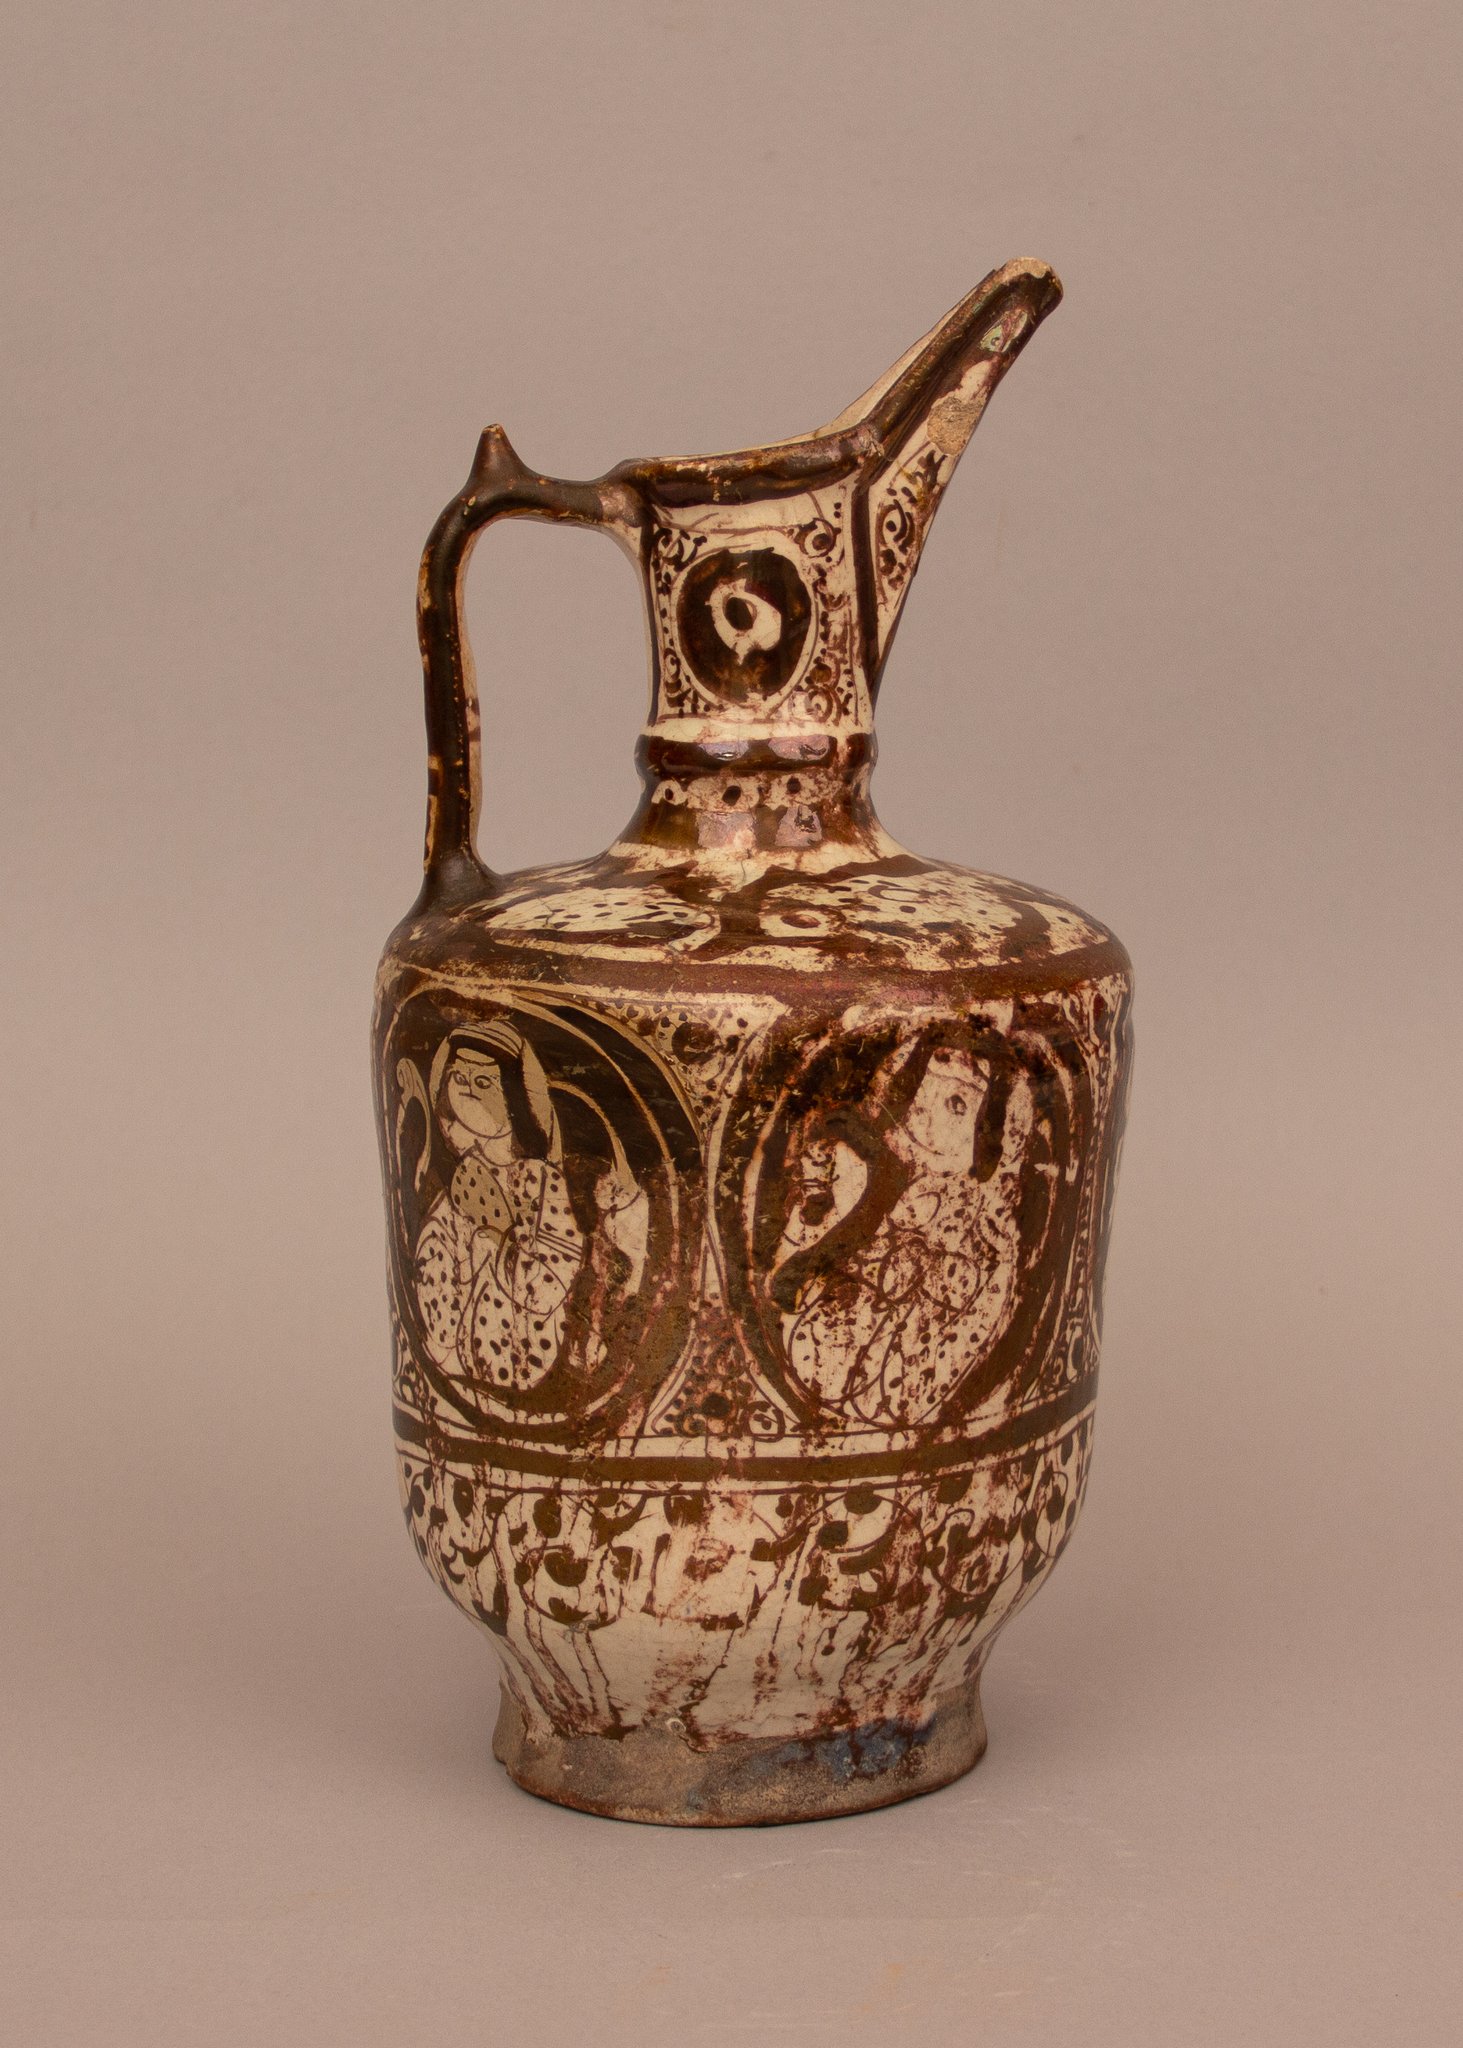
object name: ewer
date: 1101-1300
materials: stonepaste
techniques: luster painting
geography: iran